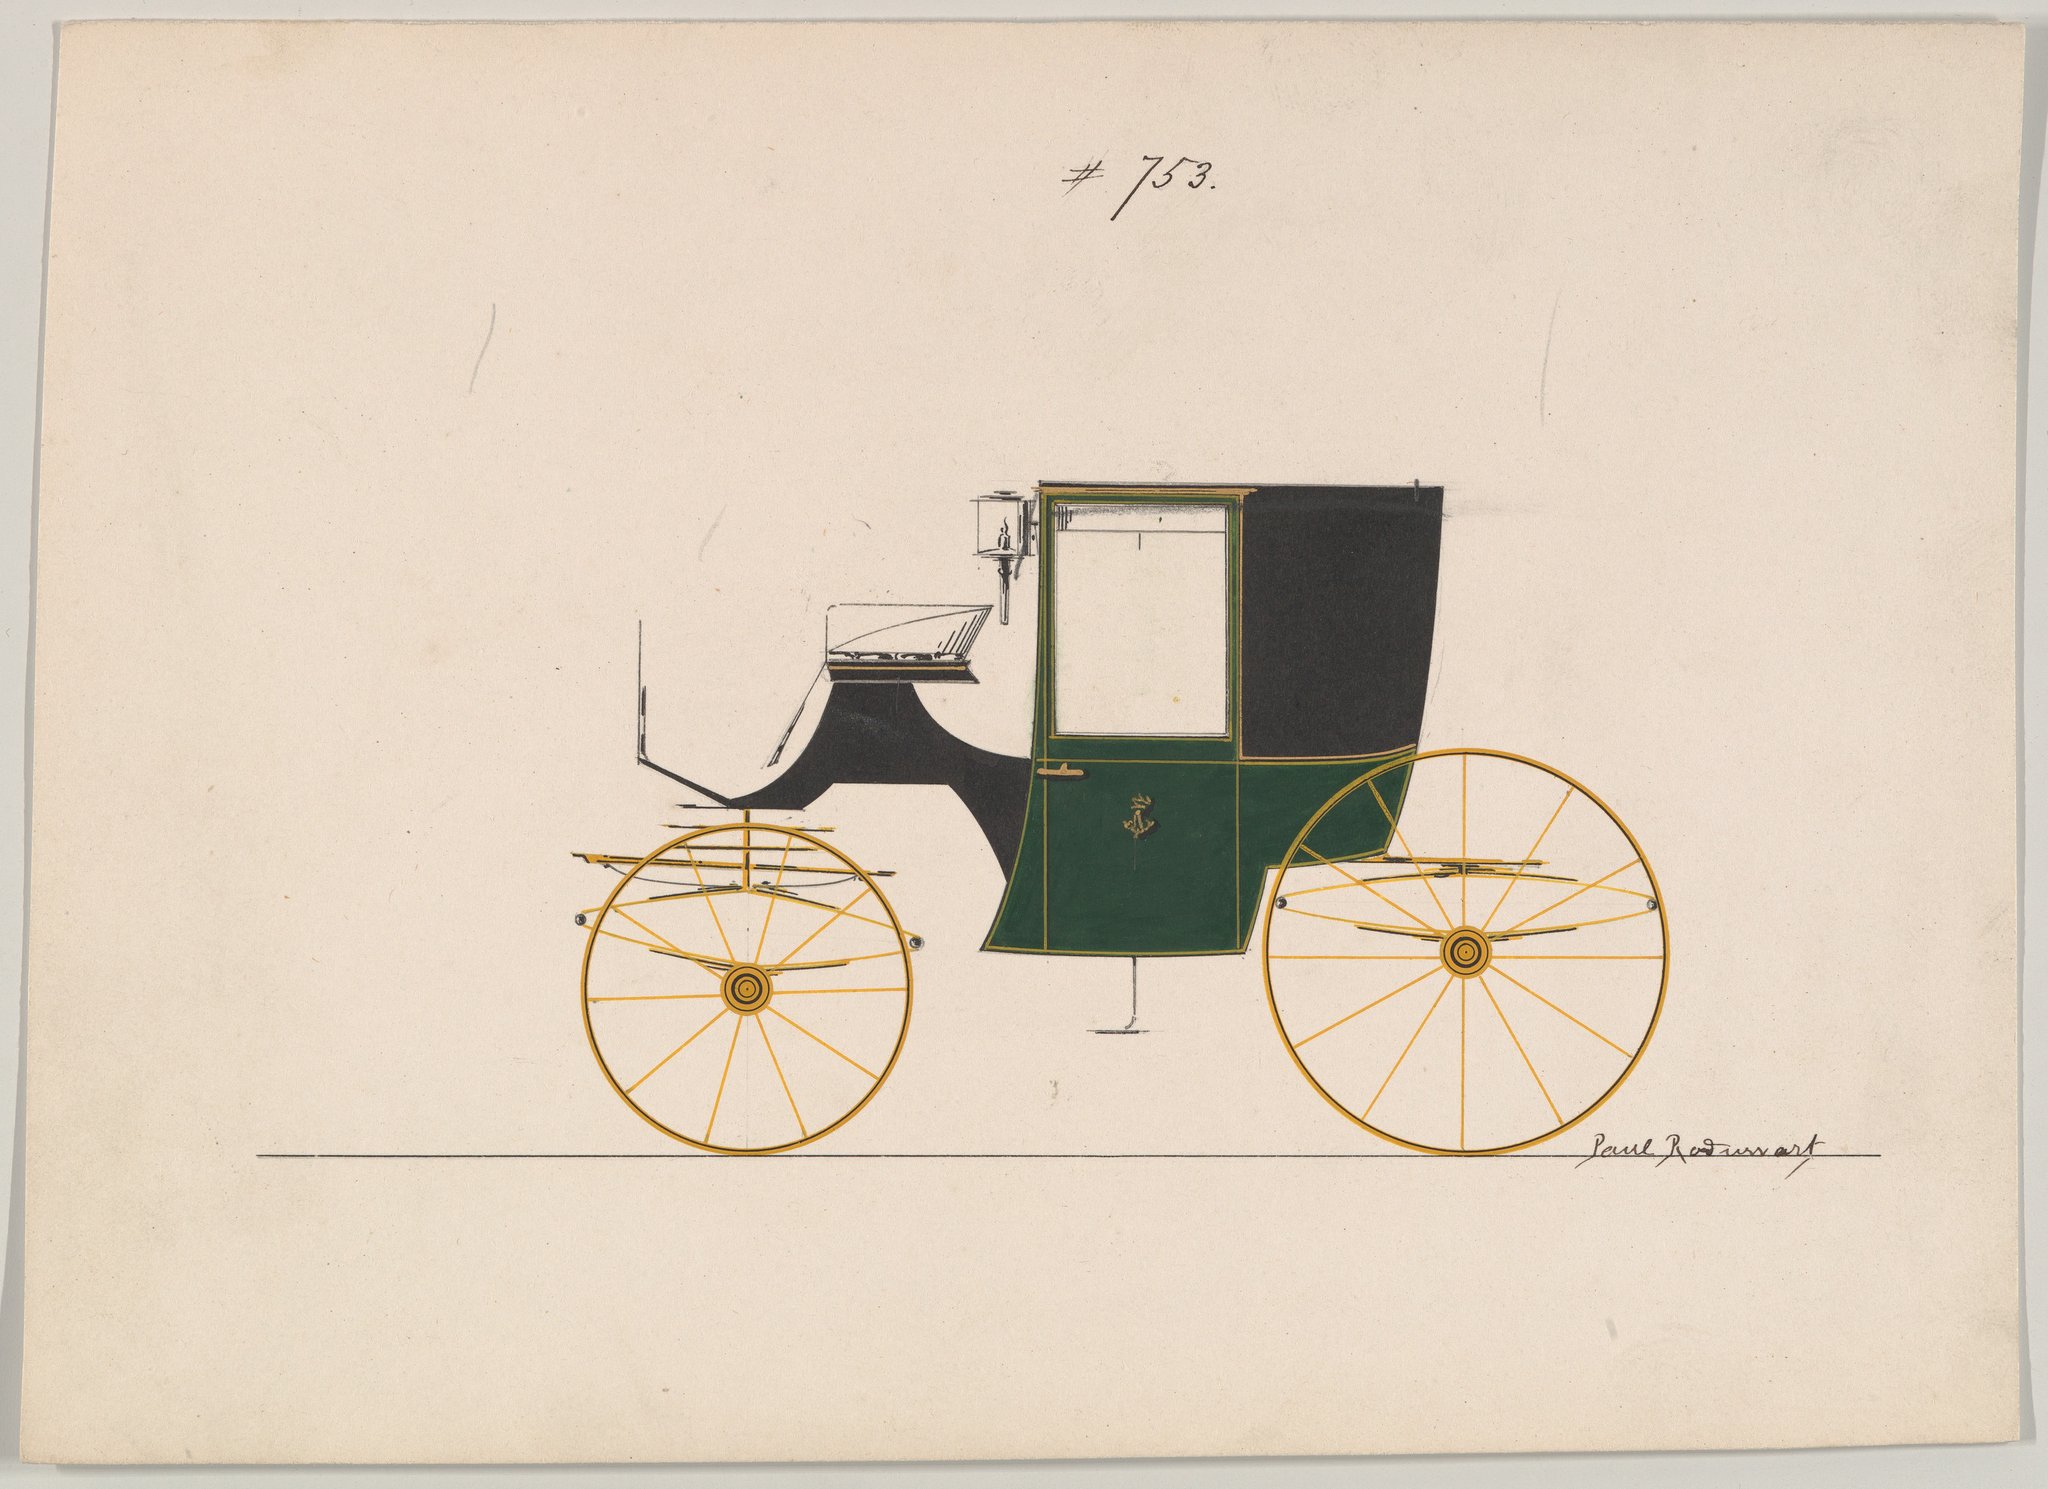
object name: drawing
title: Coupe #753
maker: brewster & co.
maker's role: manufacturer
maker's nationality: american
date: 1860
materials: gouache, ink, watercolor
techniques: pen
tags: carriages